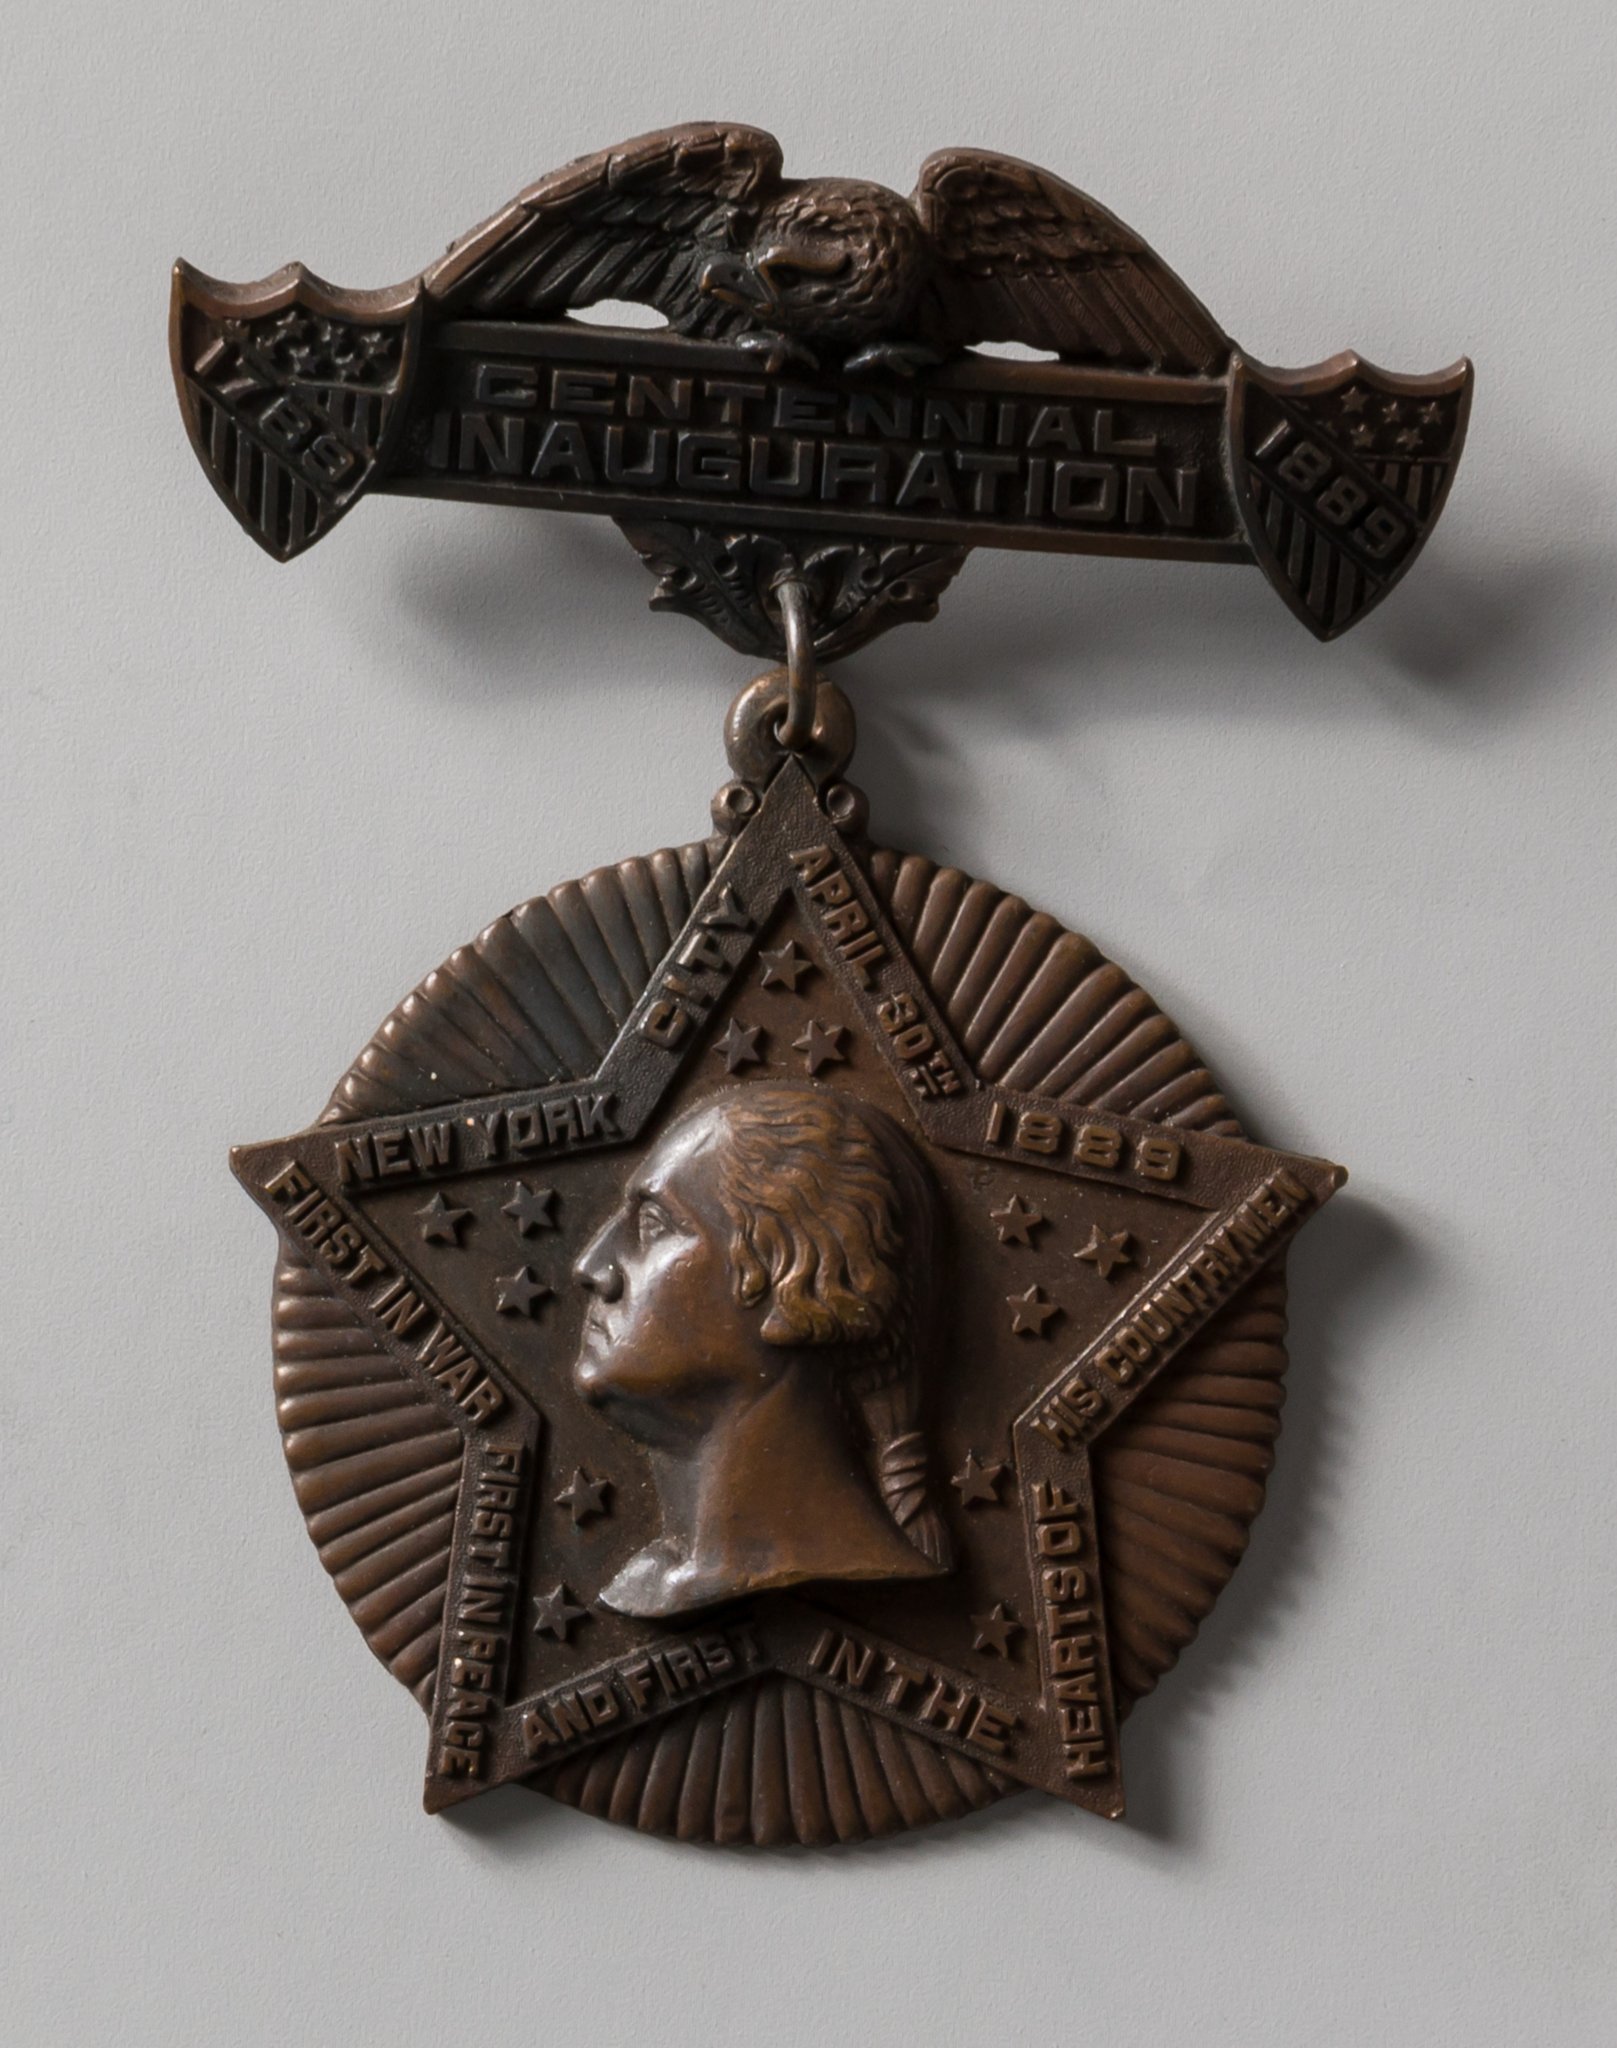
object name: medal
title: Centennial of Washington's Inauguration as President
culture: american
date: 1889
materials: metal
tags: eagles,george washington,profiles,stars